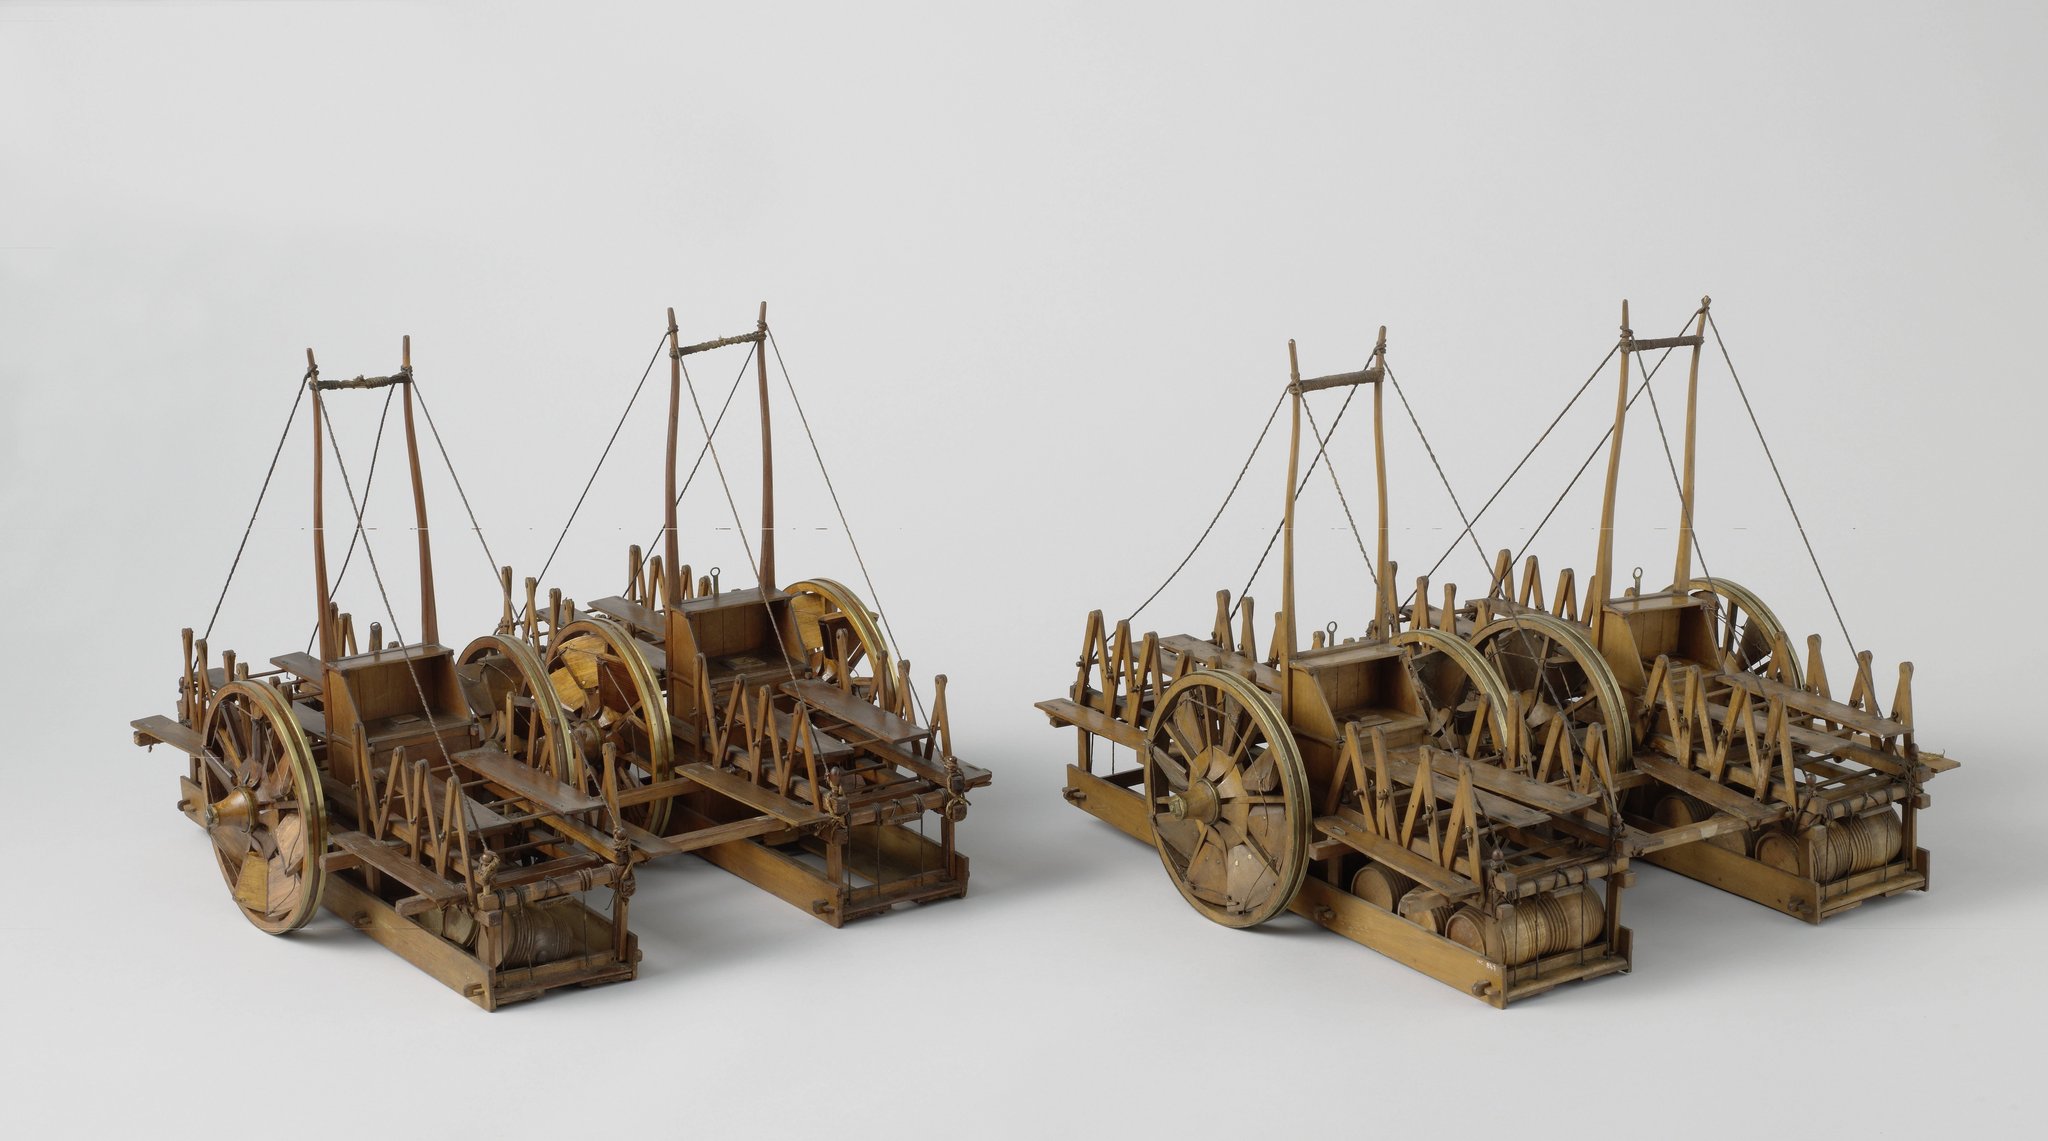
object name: demonstration model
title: Two Models of a Life-Saving Cart for Shipwrecks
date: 1832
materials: brass, fiber, wood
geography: rotterdam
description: Deze toestellen - gemaakt van waterkarren van het badhuis te Scheveningen - waren bedoeld voor reddingsoperaties op het strand. Een anker met een tros werd buiten de branding gebracht en dan werd het toestel, in het water gebracht door mensen en paarden, door middel van een kaapstander op het strand buiten de branding getrokken. Een toestel werd beproefd op het strand van Scheveningen op 12 augustus 1829 in het bijzijn van Sir Sidney Smith zelf en J.P. Asmus; het weer was op de dag van de beproeving uitzonderlijk goed, waardoor de resultaten van de proef niet als representatief werden geoordeeld.